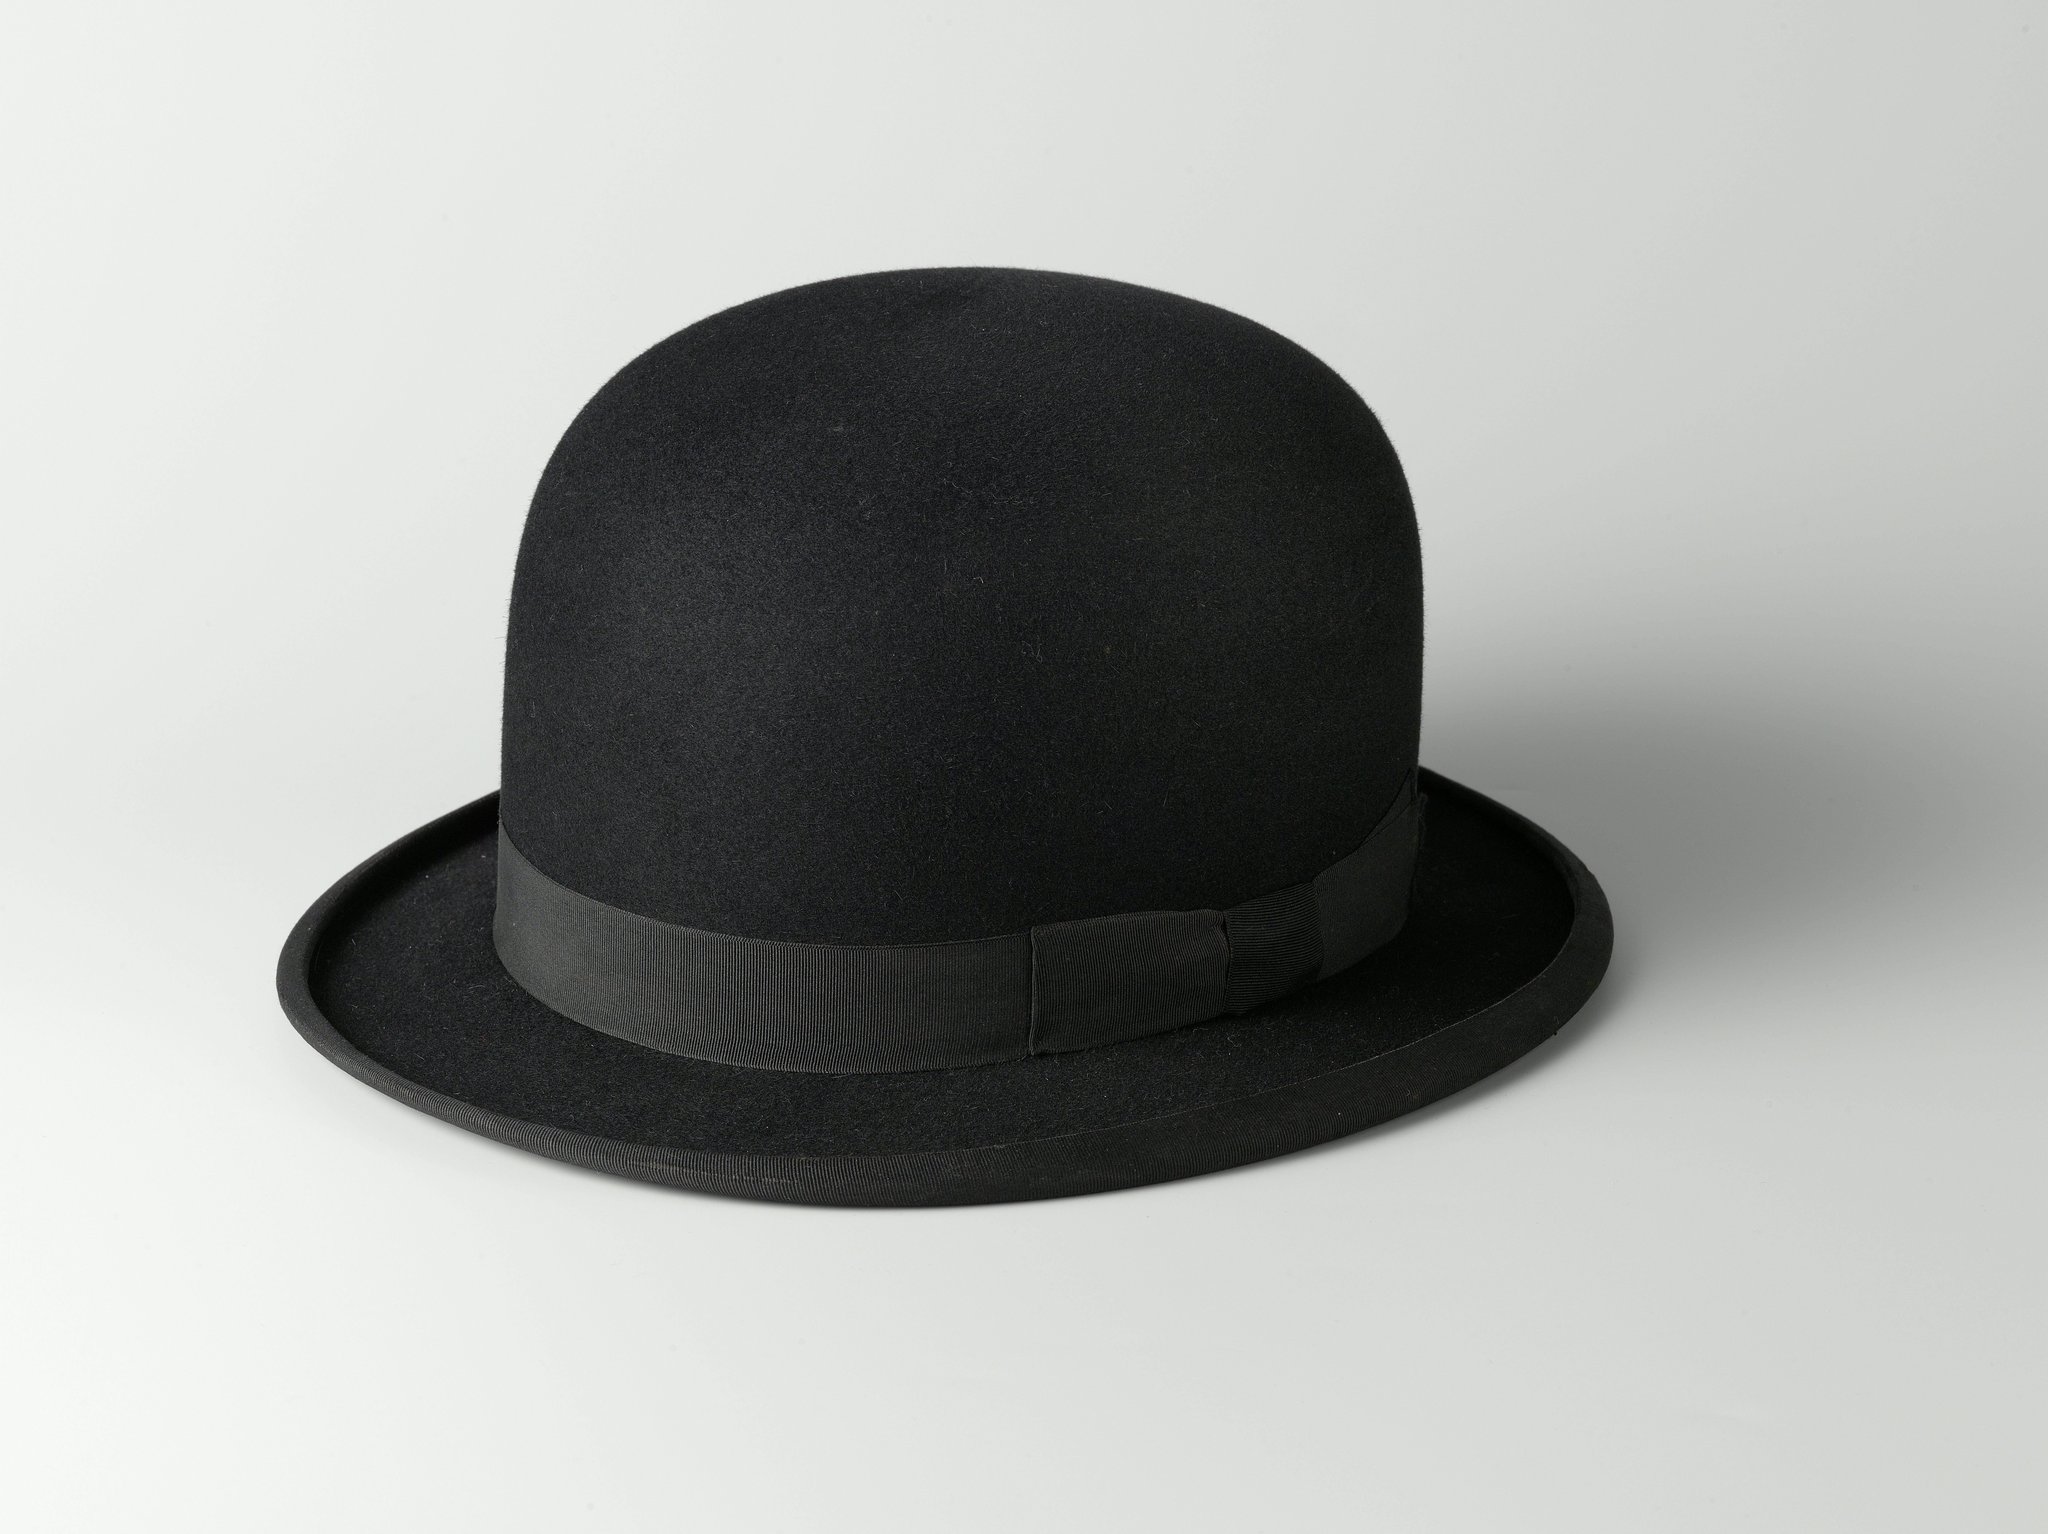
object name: dophoed, bolhoed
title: Bowler Hat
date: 1910-1915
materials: cotton, rubber, silk, wool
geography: amsterdam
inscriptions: address: ‘N.V. J.S. Meuwsen/ Fournisseur de la Cour/ Amsterdam/ Rotterdam/ La Haye’, address: ‘A. Cassé/ Fournisseur des/ 1-ières Marques Parisiennes/ Paris’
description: Bolhoed van zwart vilt afgezet met zwart ripslint, entrée van zwart fluweel, gevoerd met witte zijde, voorzien van zwart elastiek. Hierdoor lijkt het waarschijnlijk dat de hoed door een amazone is gedragen.